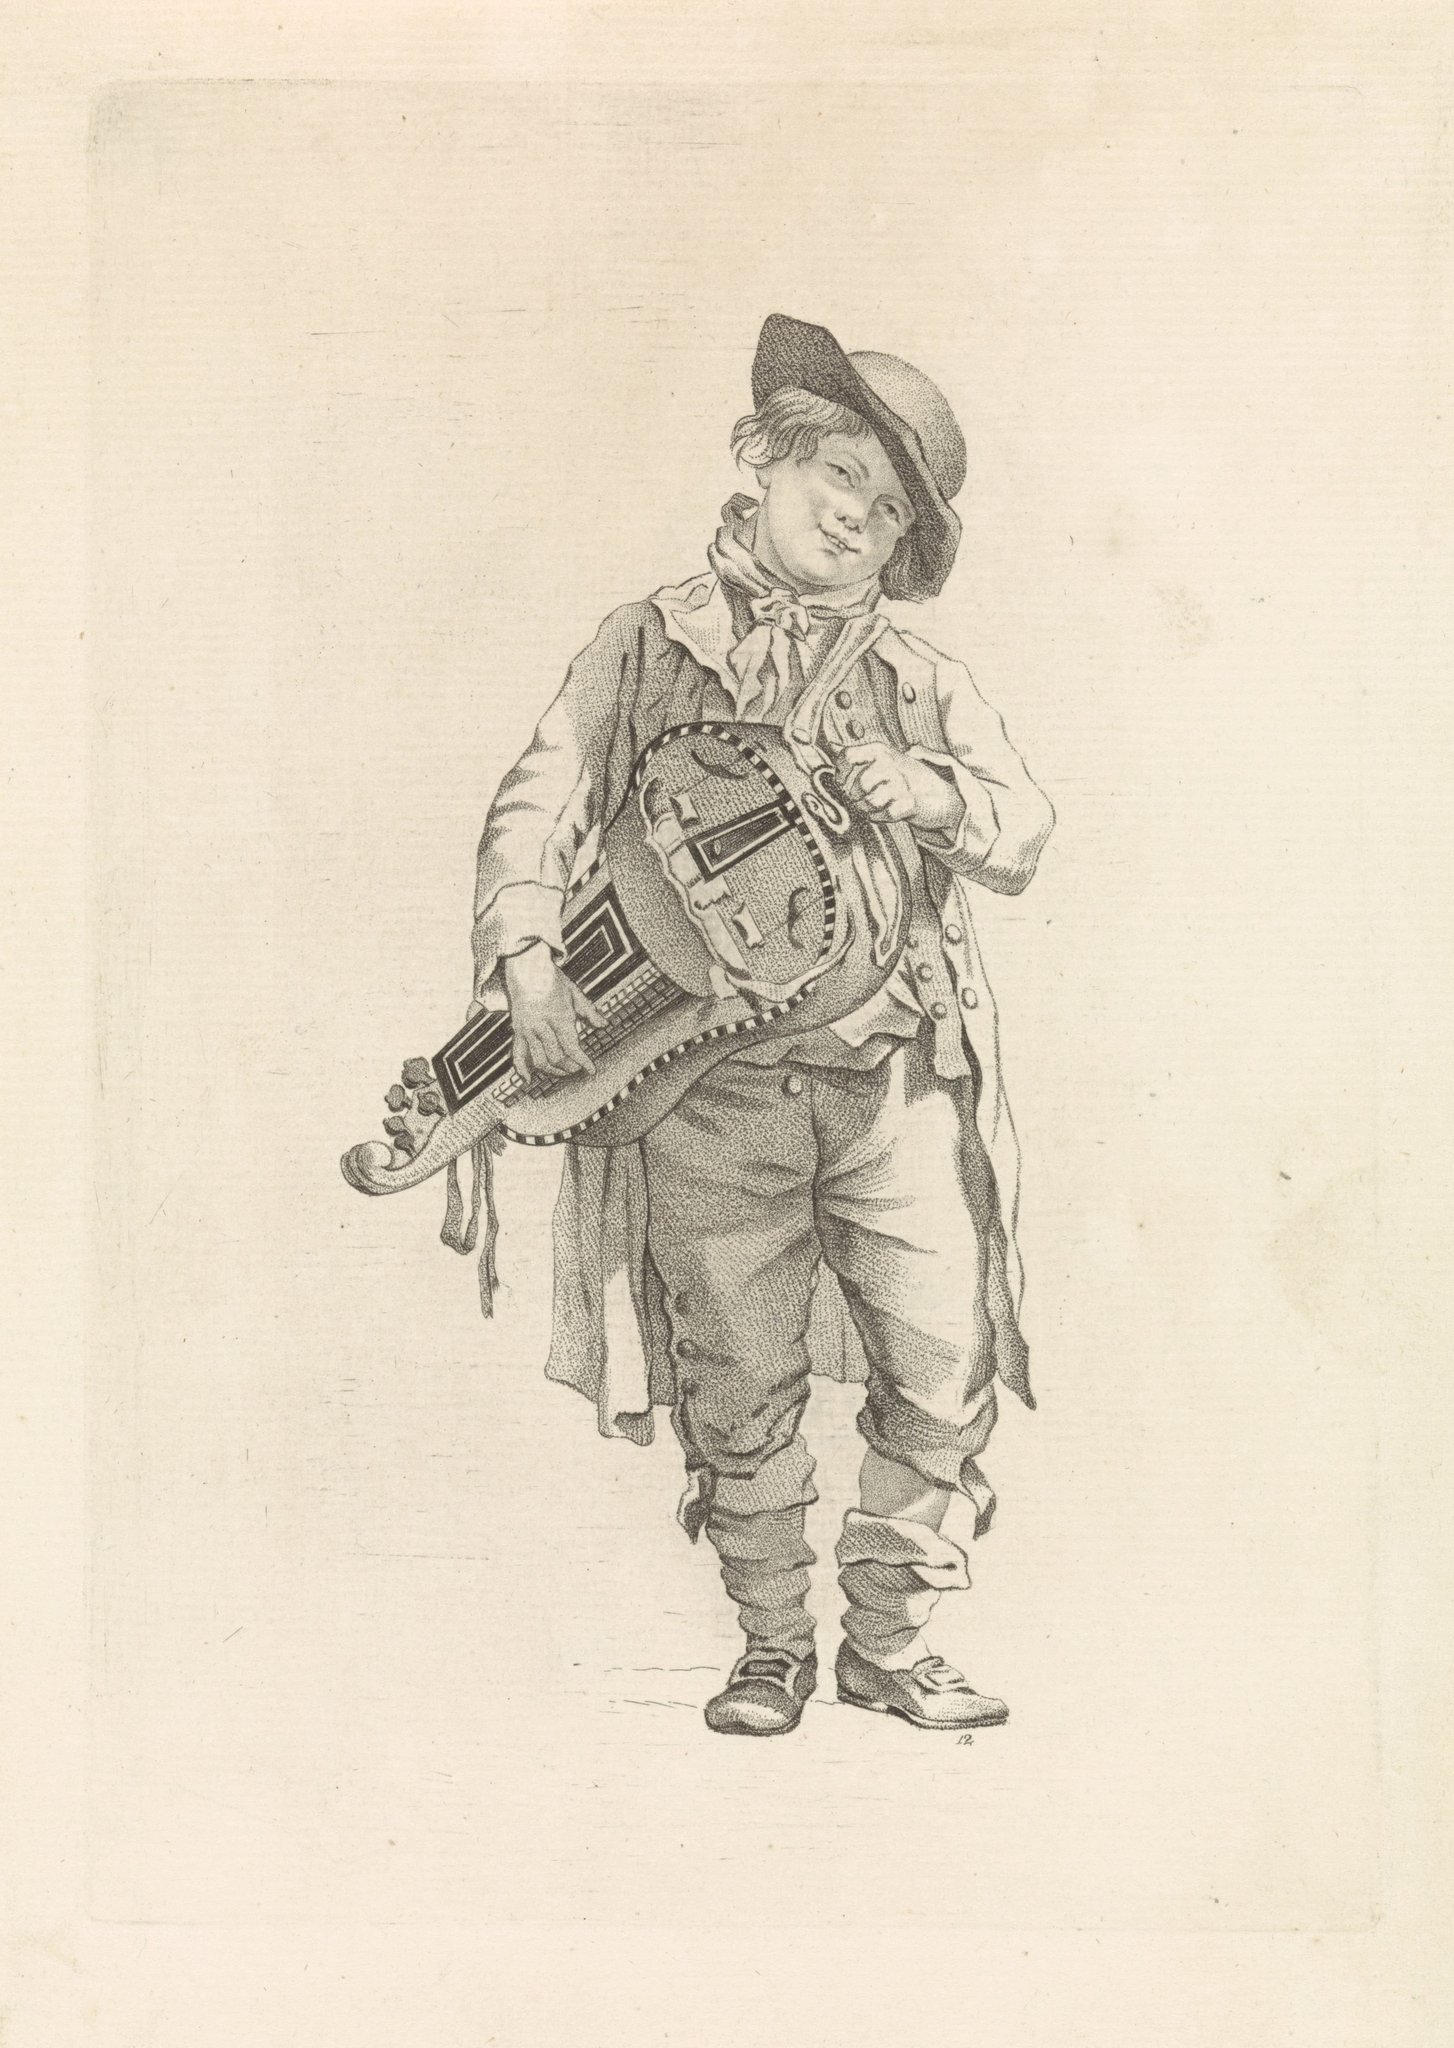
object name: print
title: Draailierspeler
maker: Anonymous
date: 1772-1791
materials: paper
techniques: printmaking, etching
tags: youth, adolescent, head-gear: hat (+ men's clothes), hurdy-gurdy player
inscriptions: collector's mark: Lugt 2228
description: Gespiegelde heruitgave van een verloren gegane plaat (zie RP-P-1991-443), met nummer. De originele prent verscheen vanaf 1818 als onderdeel van een 33-delige reeks prenten door Mathias de Sallieth, samengebonden in: Perkois, Jacobus, Prins, Johannes Huibert. Verzameling van verschillende gekleede mans- en vrouwenstanden, ter oefening van jonge schilders en liefhebbers. Rotterdam: Johannes Immerzeel, 1818.